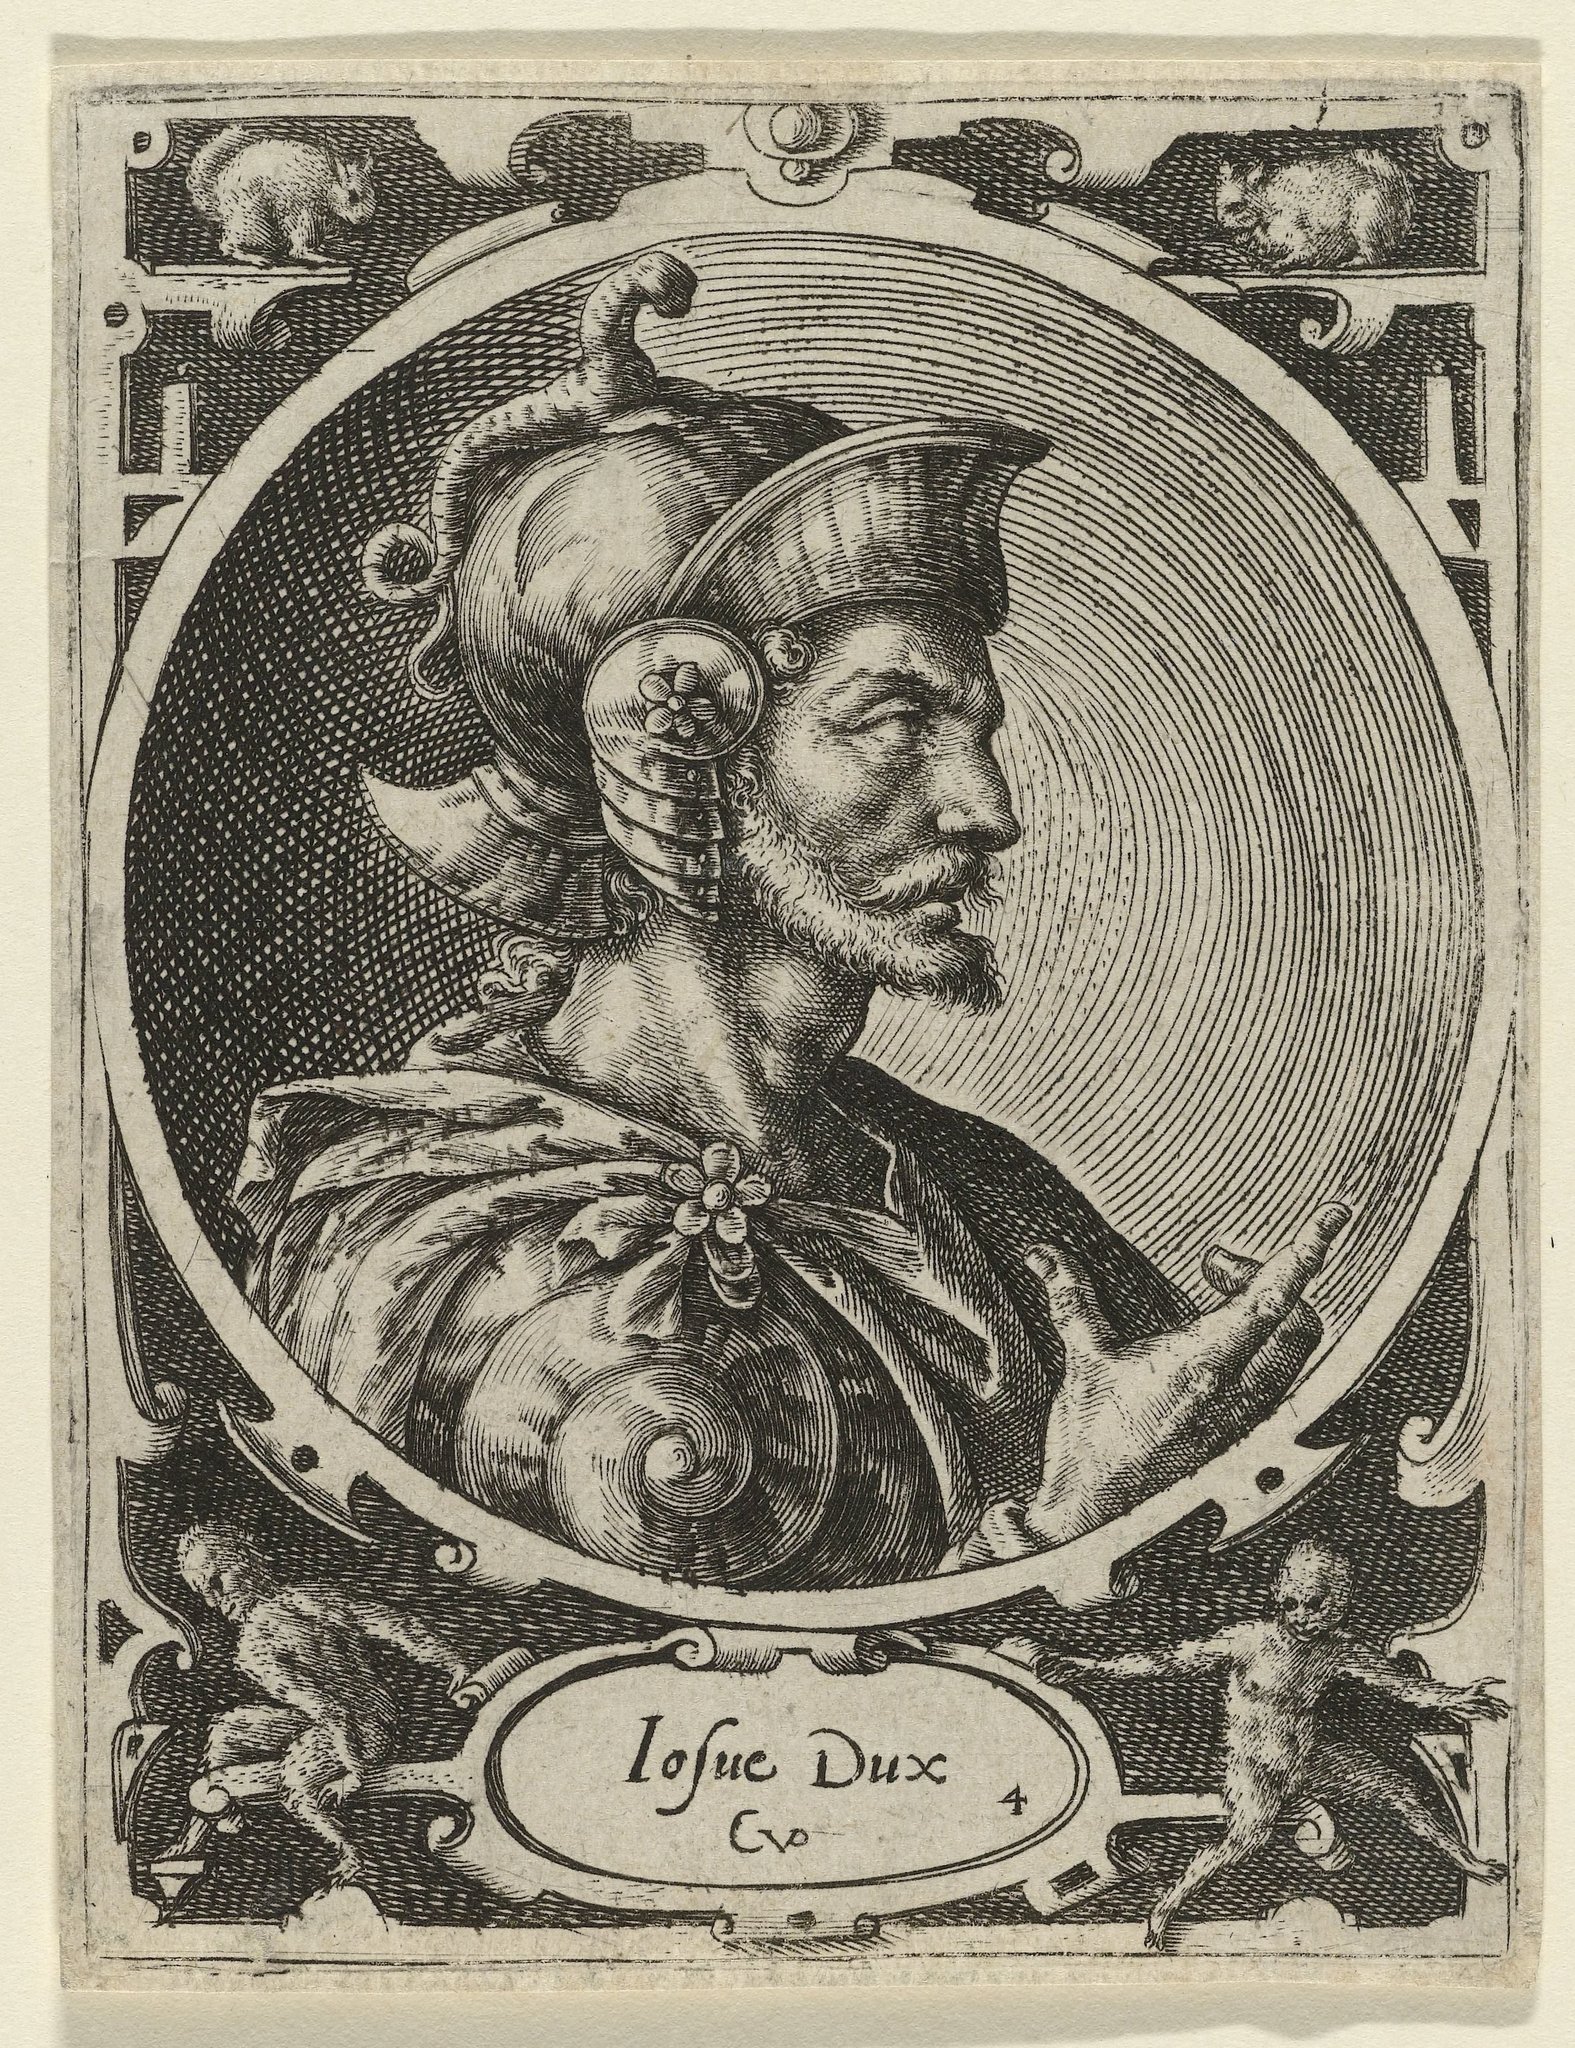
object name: ornament print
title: Medaillons met de hoofden van de negen helden in een omlijsting van rolwerk met dieren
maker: crispijn van de passe (i)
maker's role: draughtsman, print maker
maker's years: 1564-1637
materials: paper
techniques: engraving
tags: joshua (not in biblical context)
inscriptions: : ‘4’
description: Buste van Jozua, in ronde lijst, gevat in ornament met verschillende dieren. Middenonder cartouche met naam: Josue Dux. Genummerd 4.